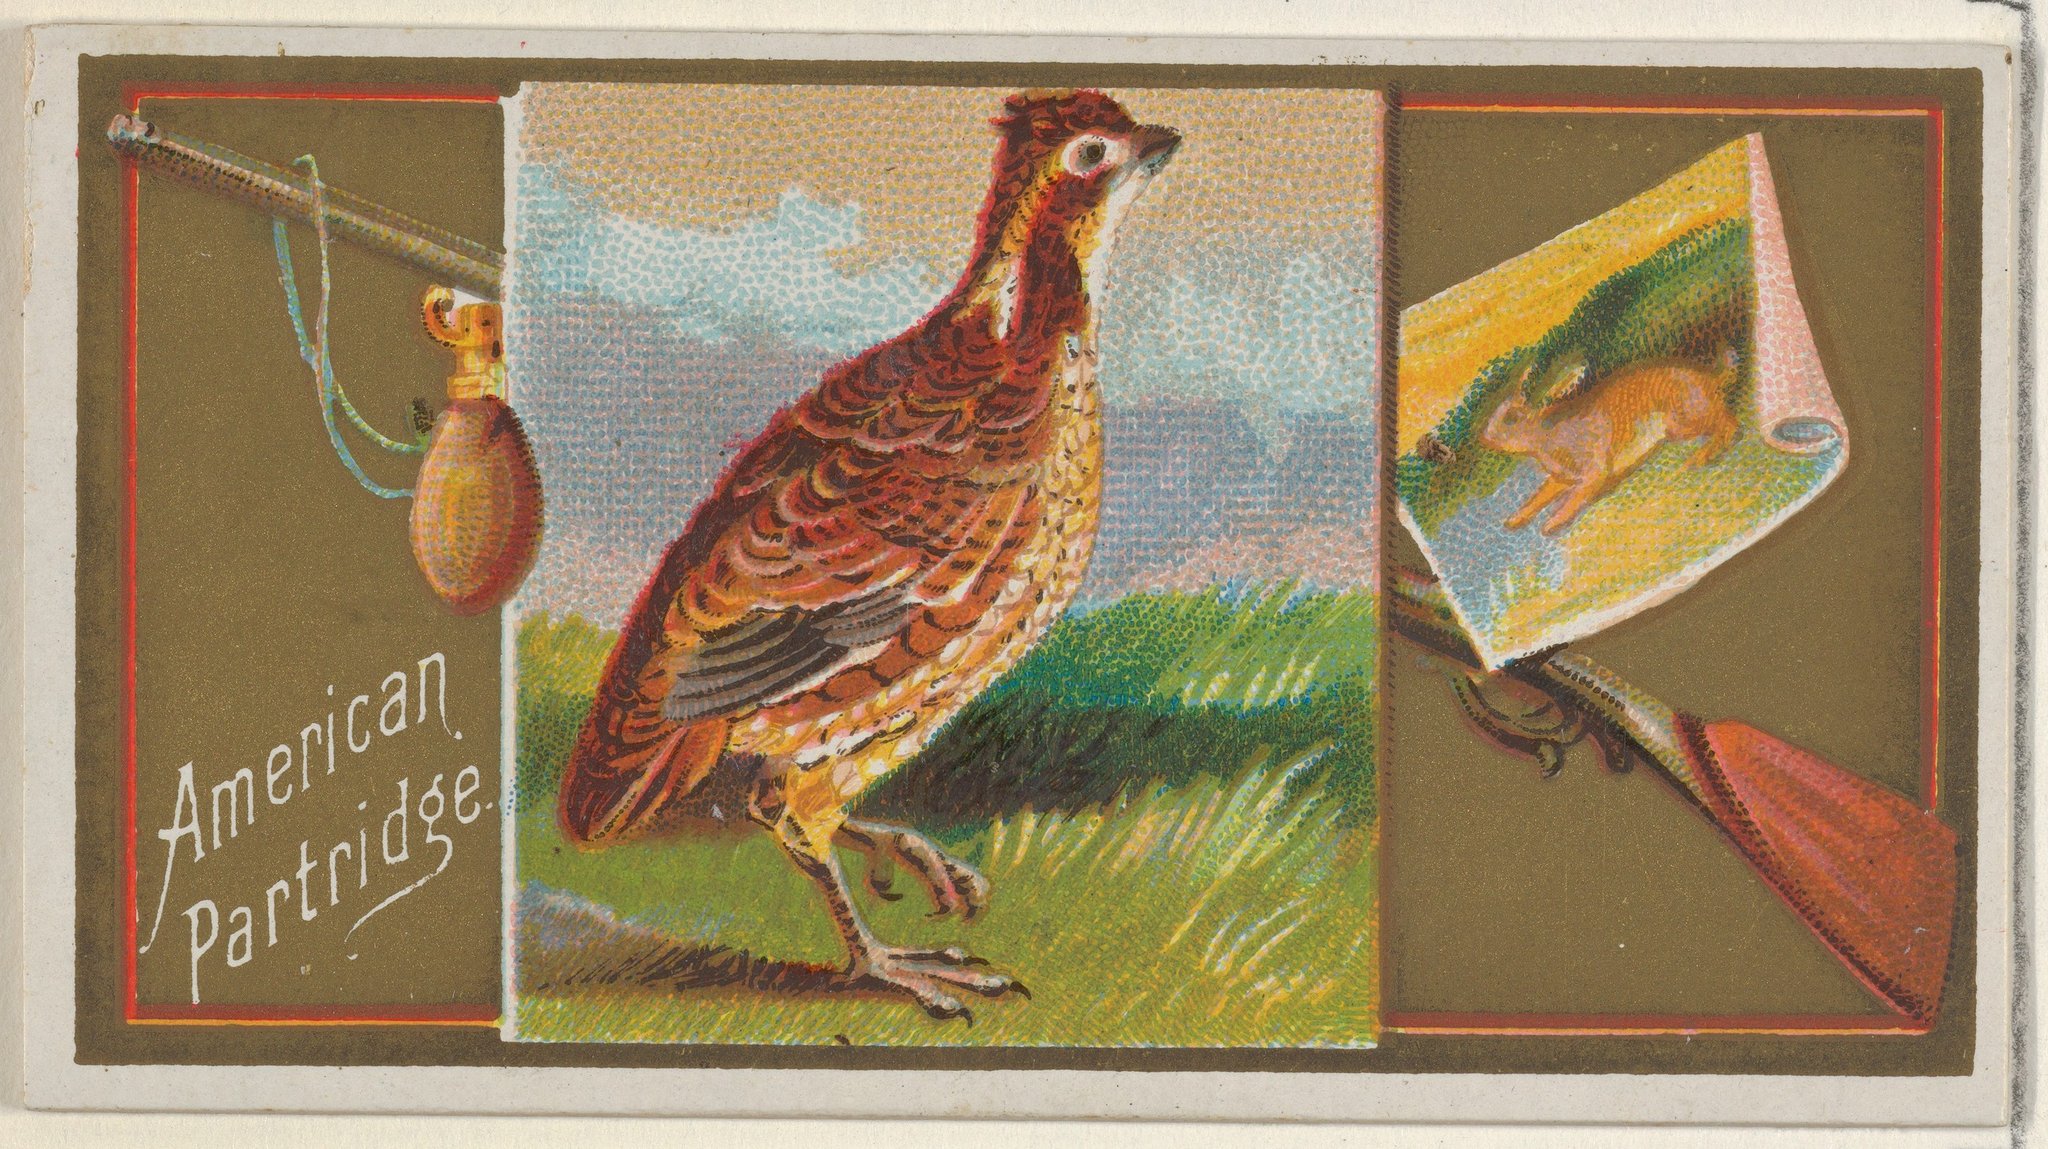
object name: print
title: American Partridge, from the Game Birds series (N13) for Allen & Ginter Cigarettes Brands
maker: allen & ginter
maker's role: publisher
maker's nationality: american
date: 1889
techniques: color lithograph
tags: birds,rabbits